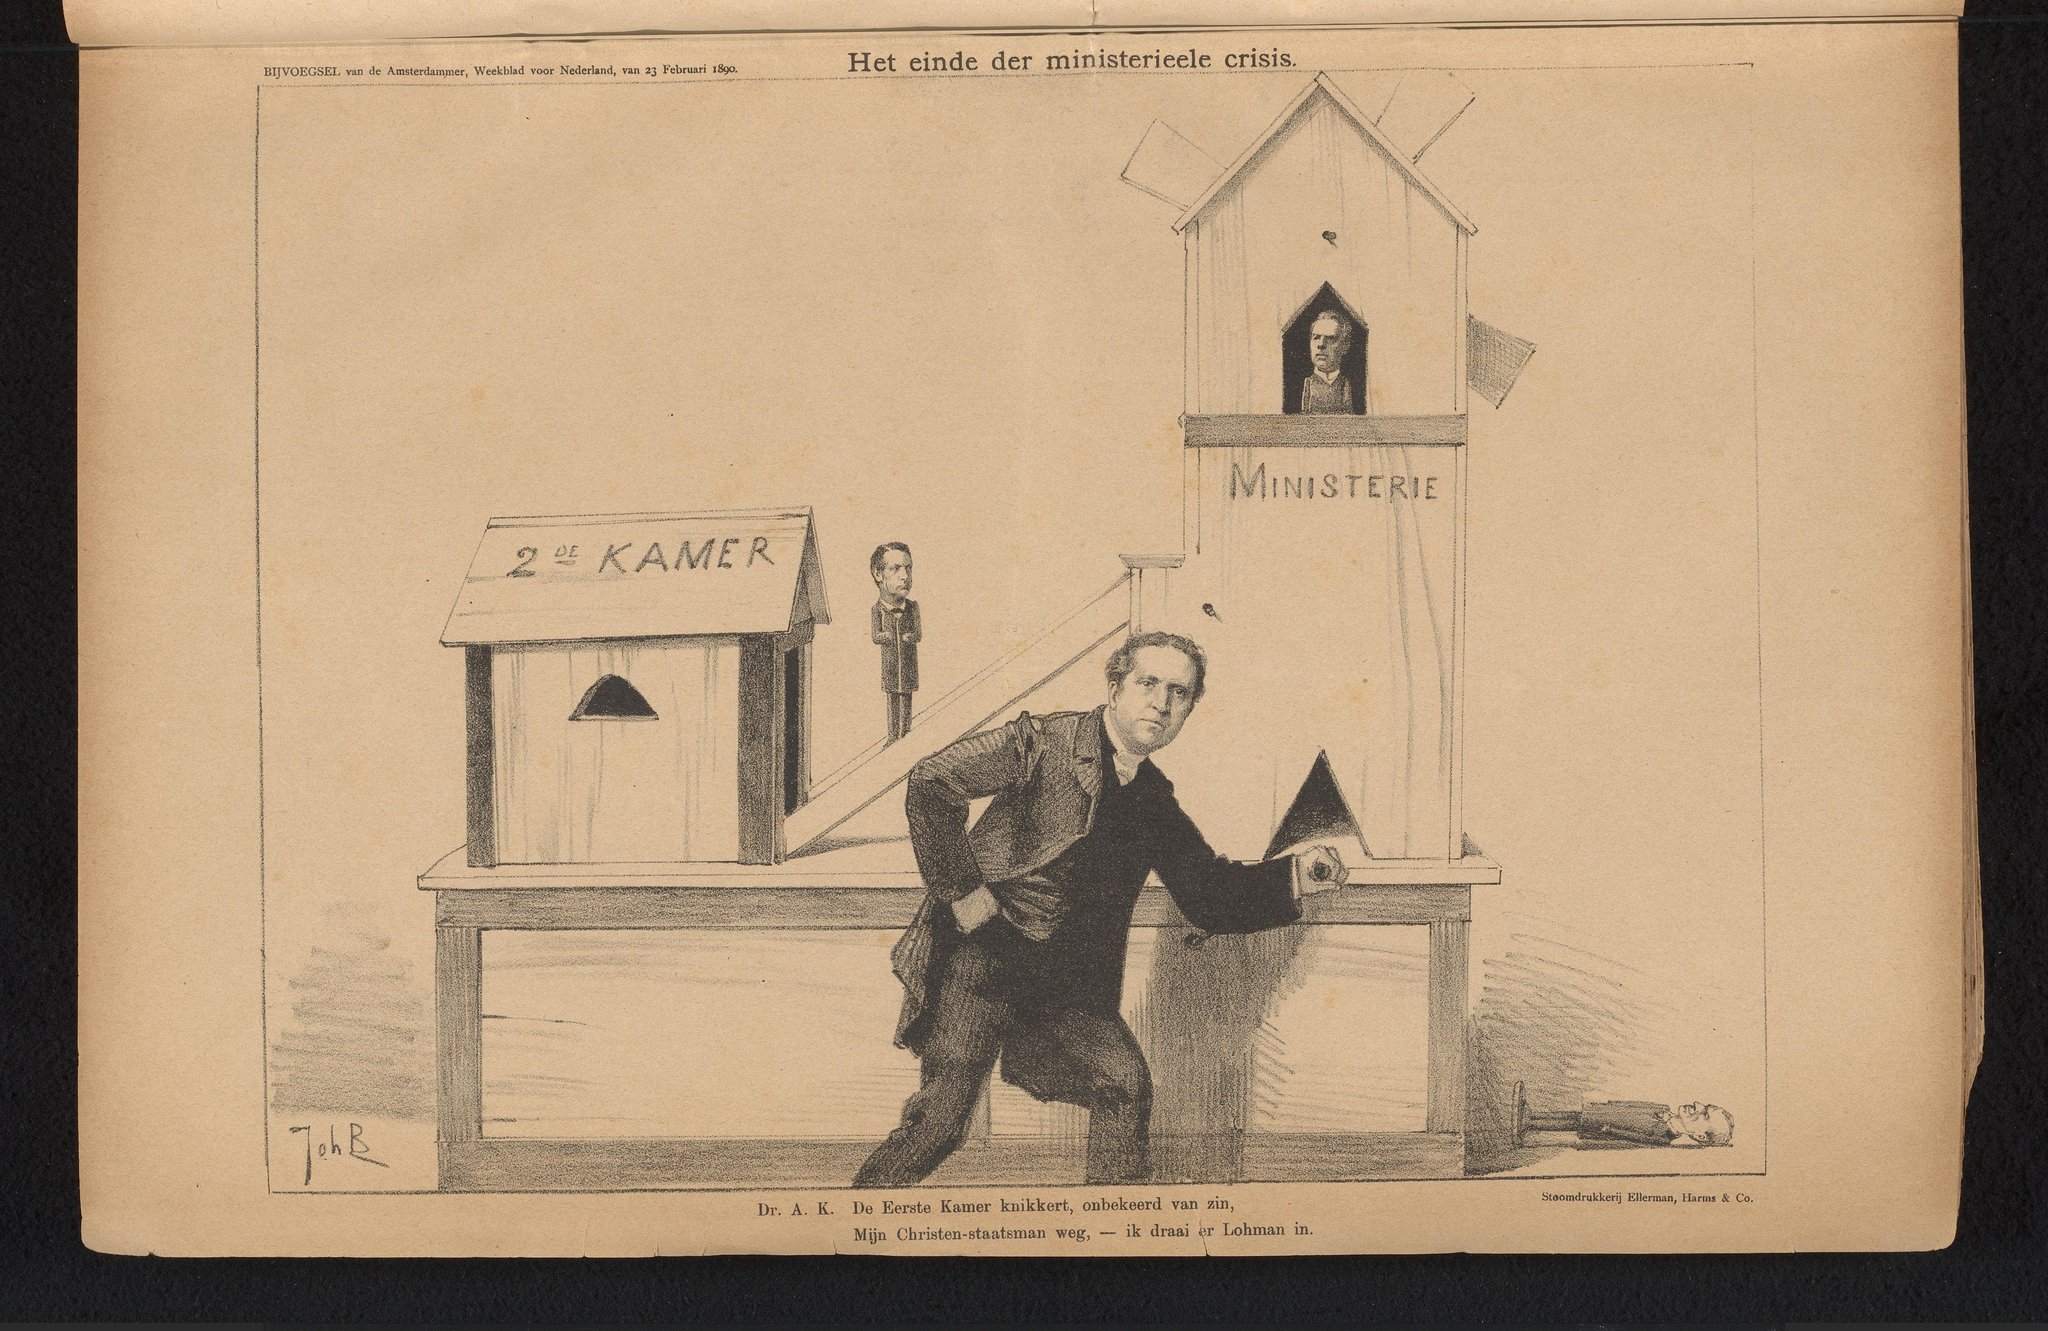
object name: cartoon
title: Het einde der ministerieele crisis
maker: johan braakensiek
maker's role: draughtsman, print maker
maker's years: 1858-1940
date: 1890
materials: paper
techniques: lithograph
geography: amsterdam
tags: jonkheer alexander frederik de savornin lohman, abraham kuyper, nijmegen, the hague, minister ~ government, politician, e.g. party leader, political caricatures and satires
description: Bij de opvolging van Keuchenius door Mackay op het ministerie van Koloniën wil Abraham Kuyper liever De Savornin Lohman op die plek hebben. Voorgesteld als een machine van hout met een molen en poppetjes waar Kuyper aan de slinger draait.